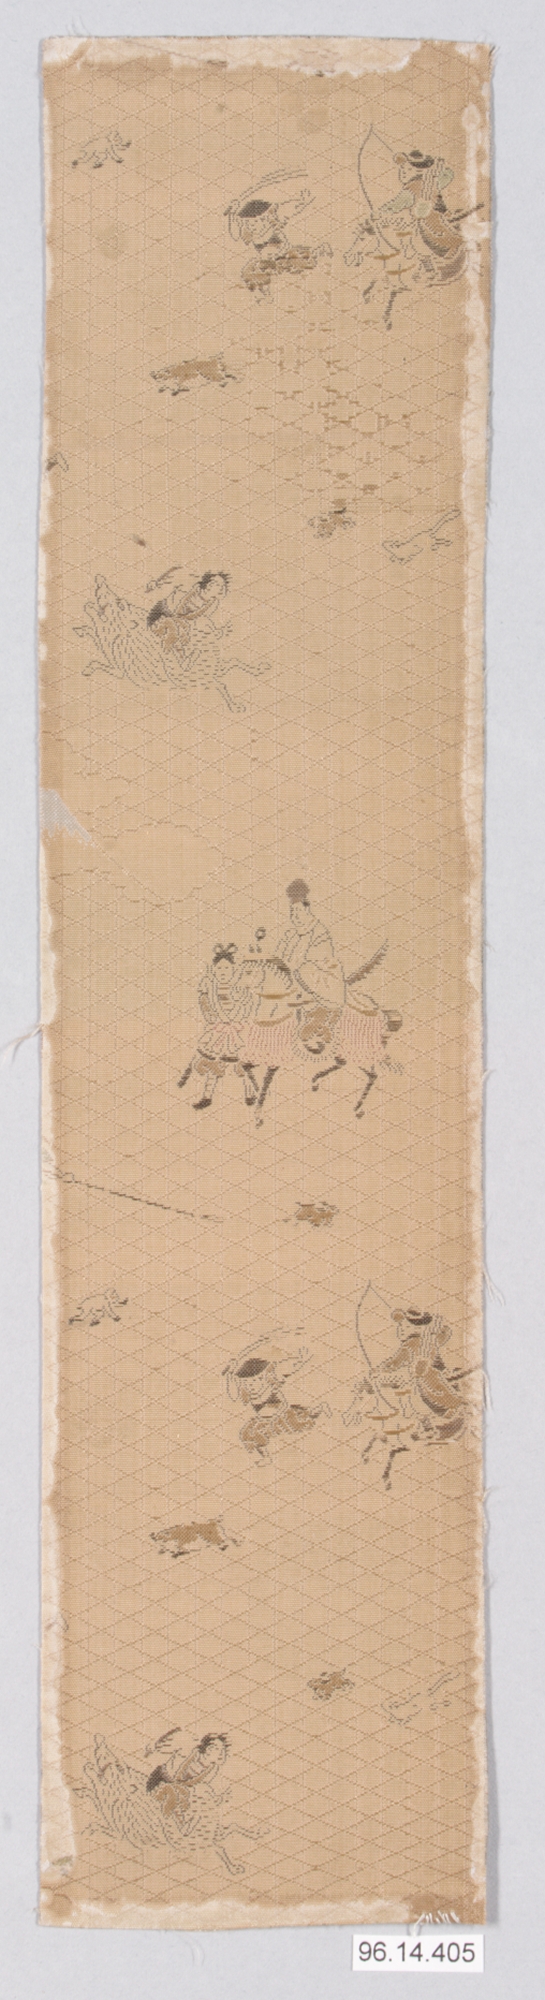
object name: piece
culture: japanese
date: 1701-1800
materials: metal thread, silk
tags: bow and arrow,men,hunting